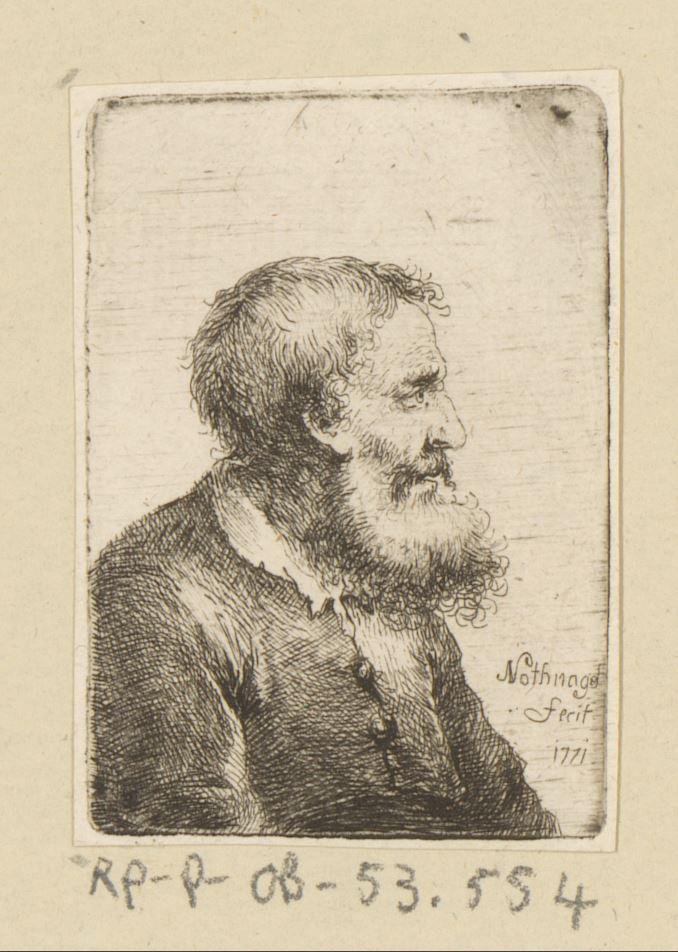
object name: print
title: Oude man met baard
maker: johann andreas benjamin nothnagel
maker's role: print maker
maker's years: 1729-1804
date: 1771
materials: paper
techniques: drypoint, etching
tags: adult man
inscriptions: collector's mark: Lugt 240